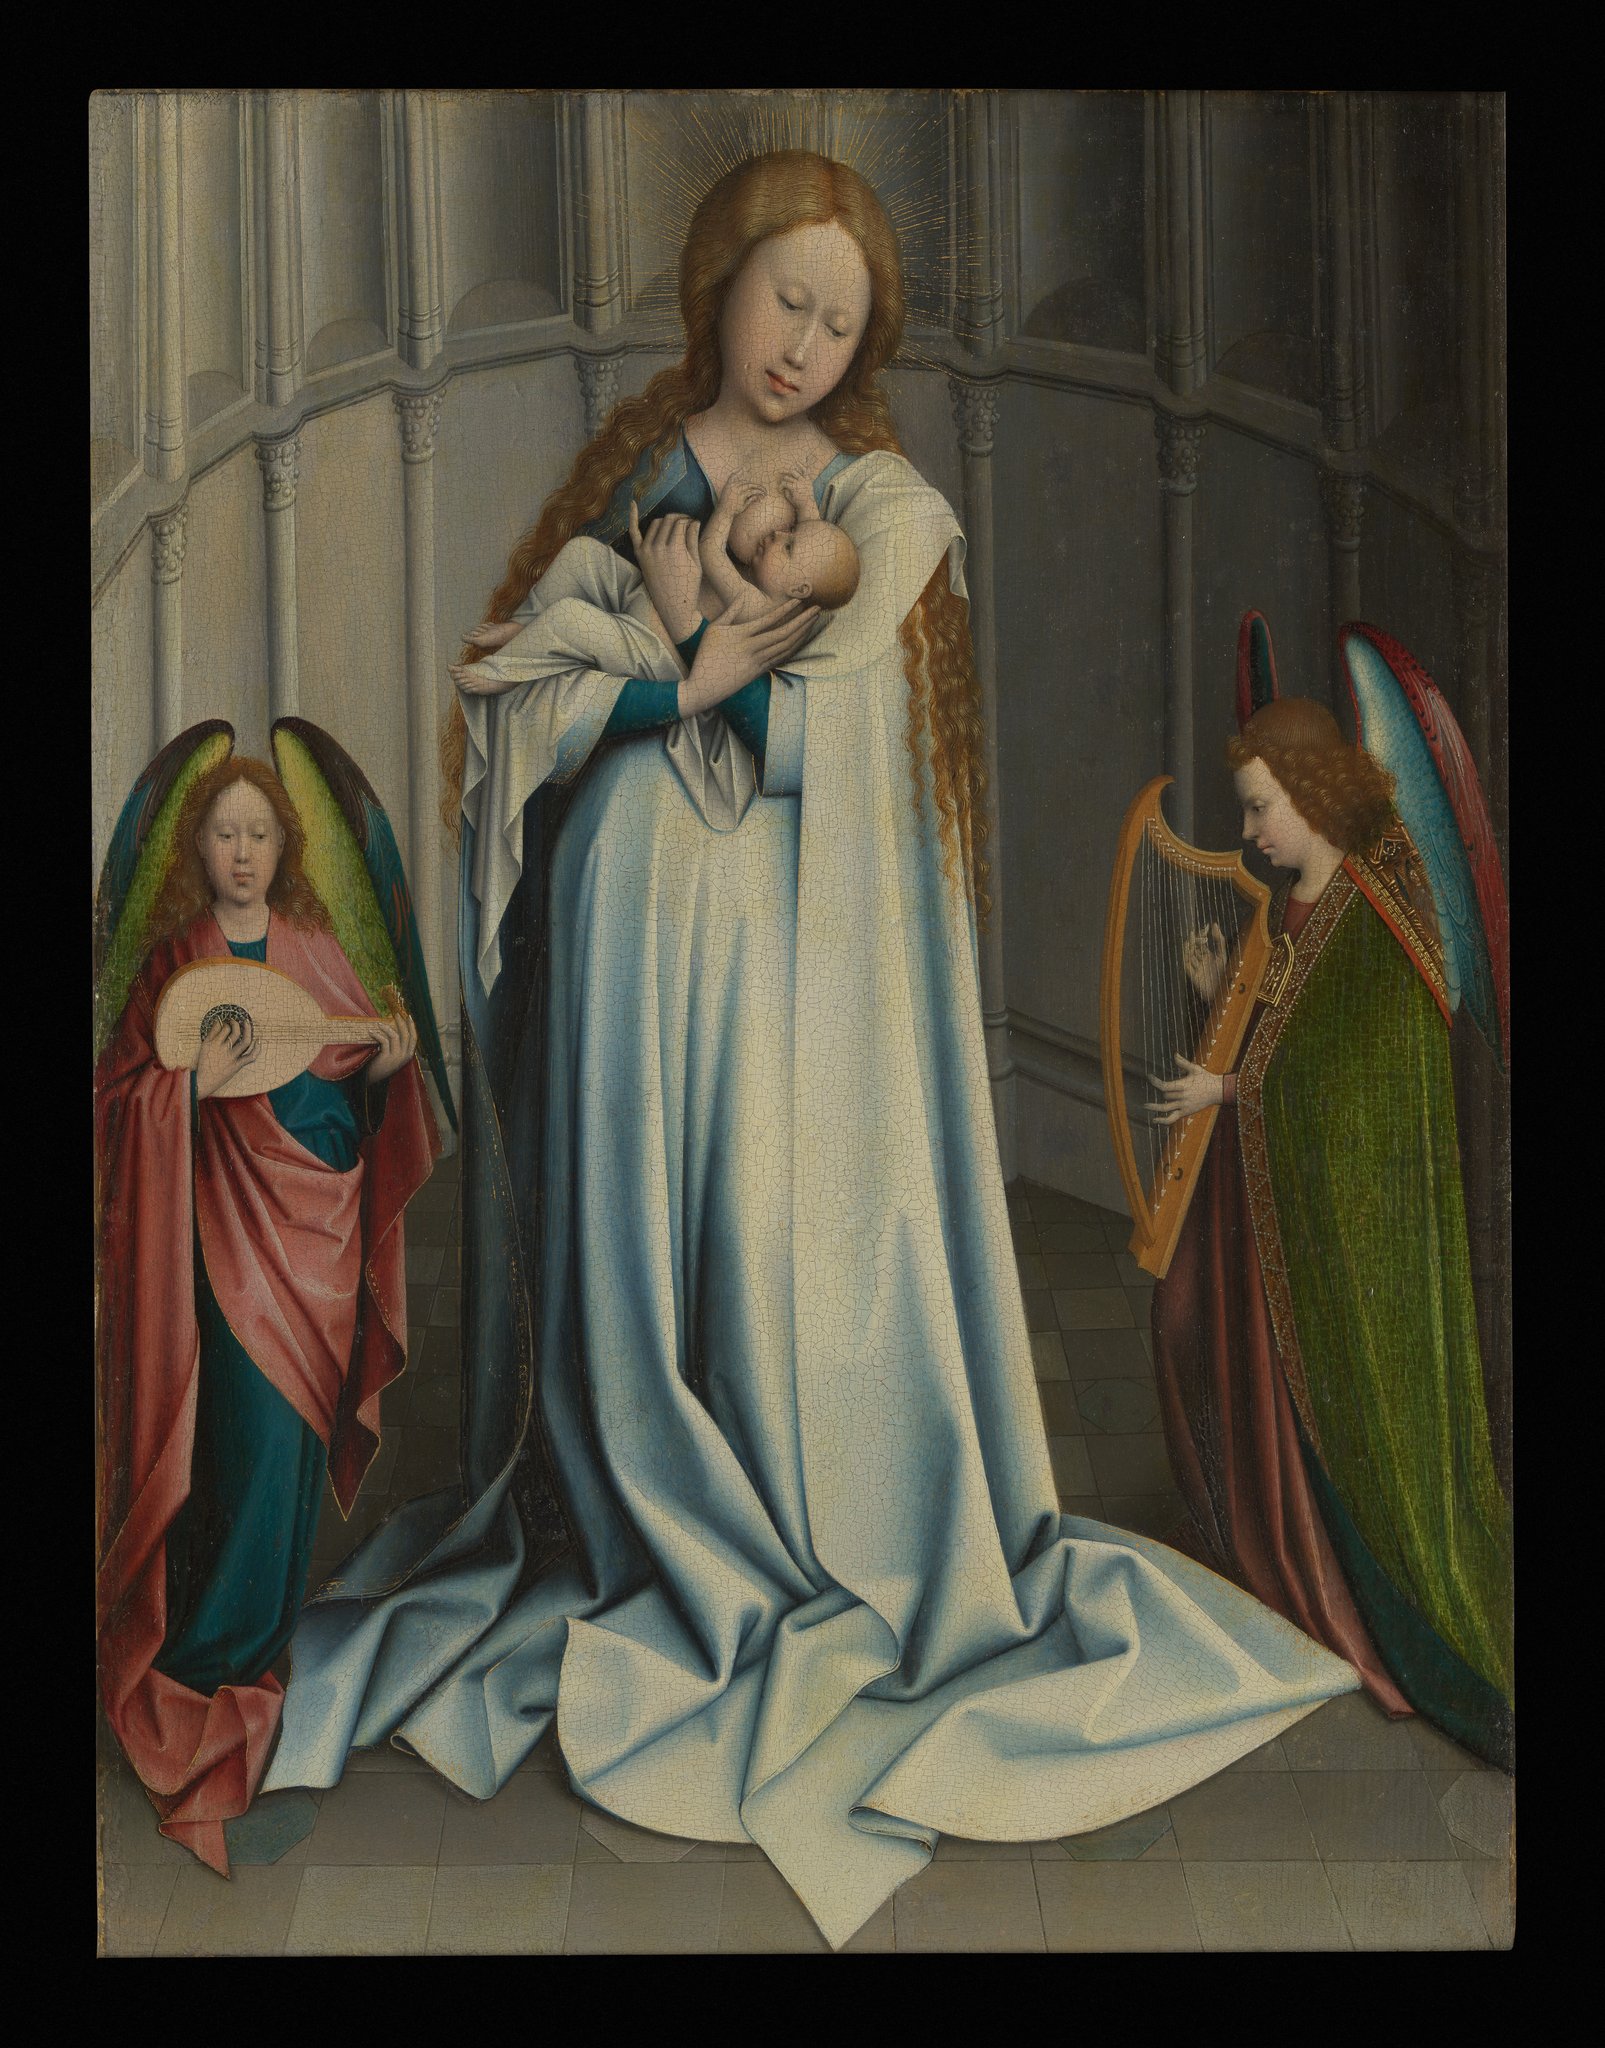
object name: painting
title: Virgin and Child in an Apse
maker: robert campin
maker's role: artist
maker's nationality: netherlandish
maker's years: 1375-1444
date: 1475-1485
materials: canvas, oil, wood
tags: interiors,harps,angels,madonna and child,jesus,nursing